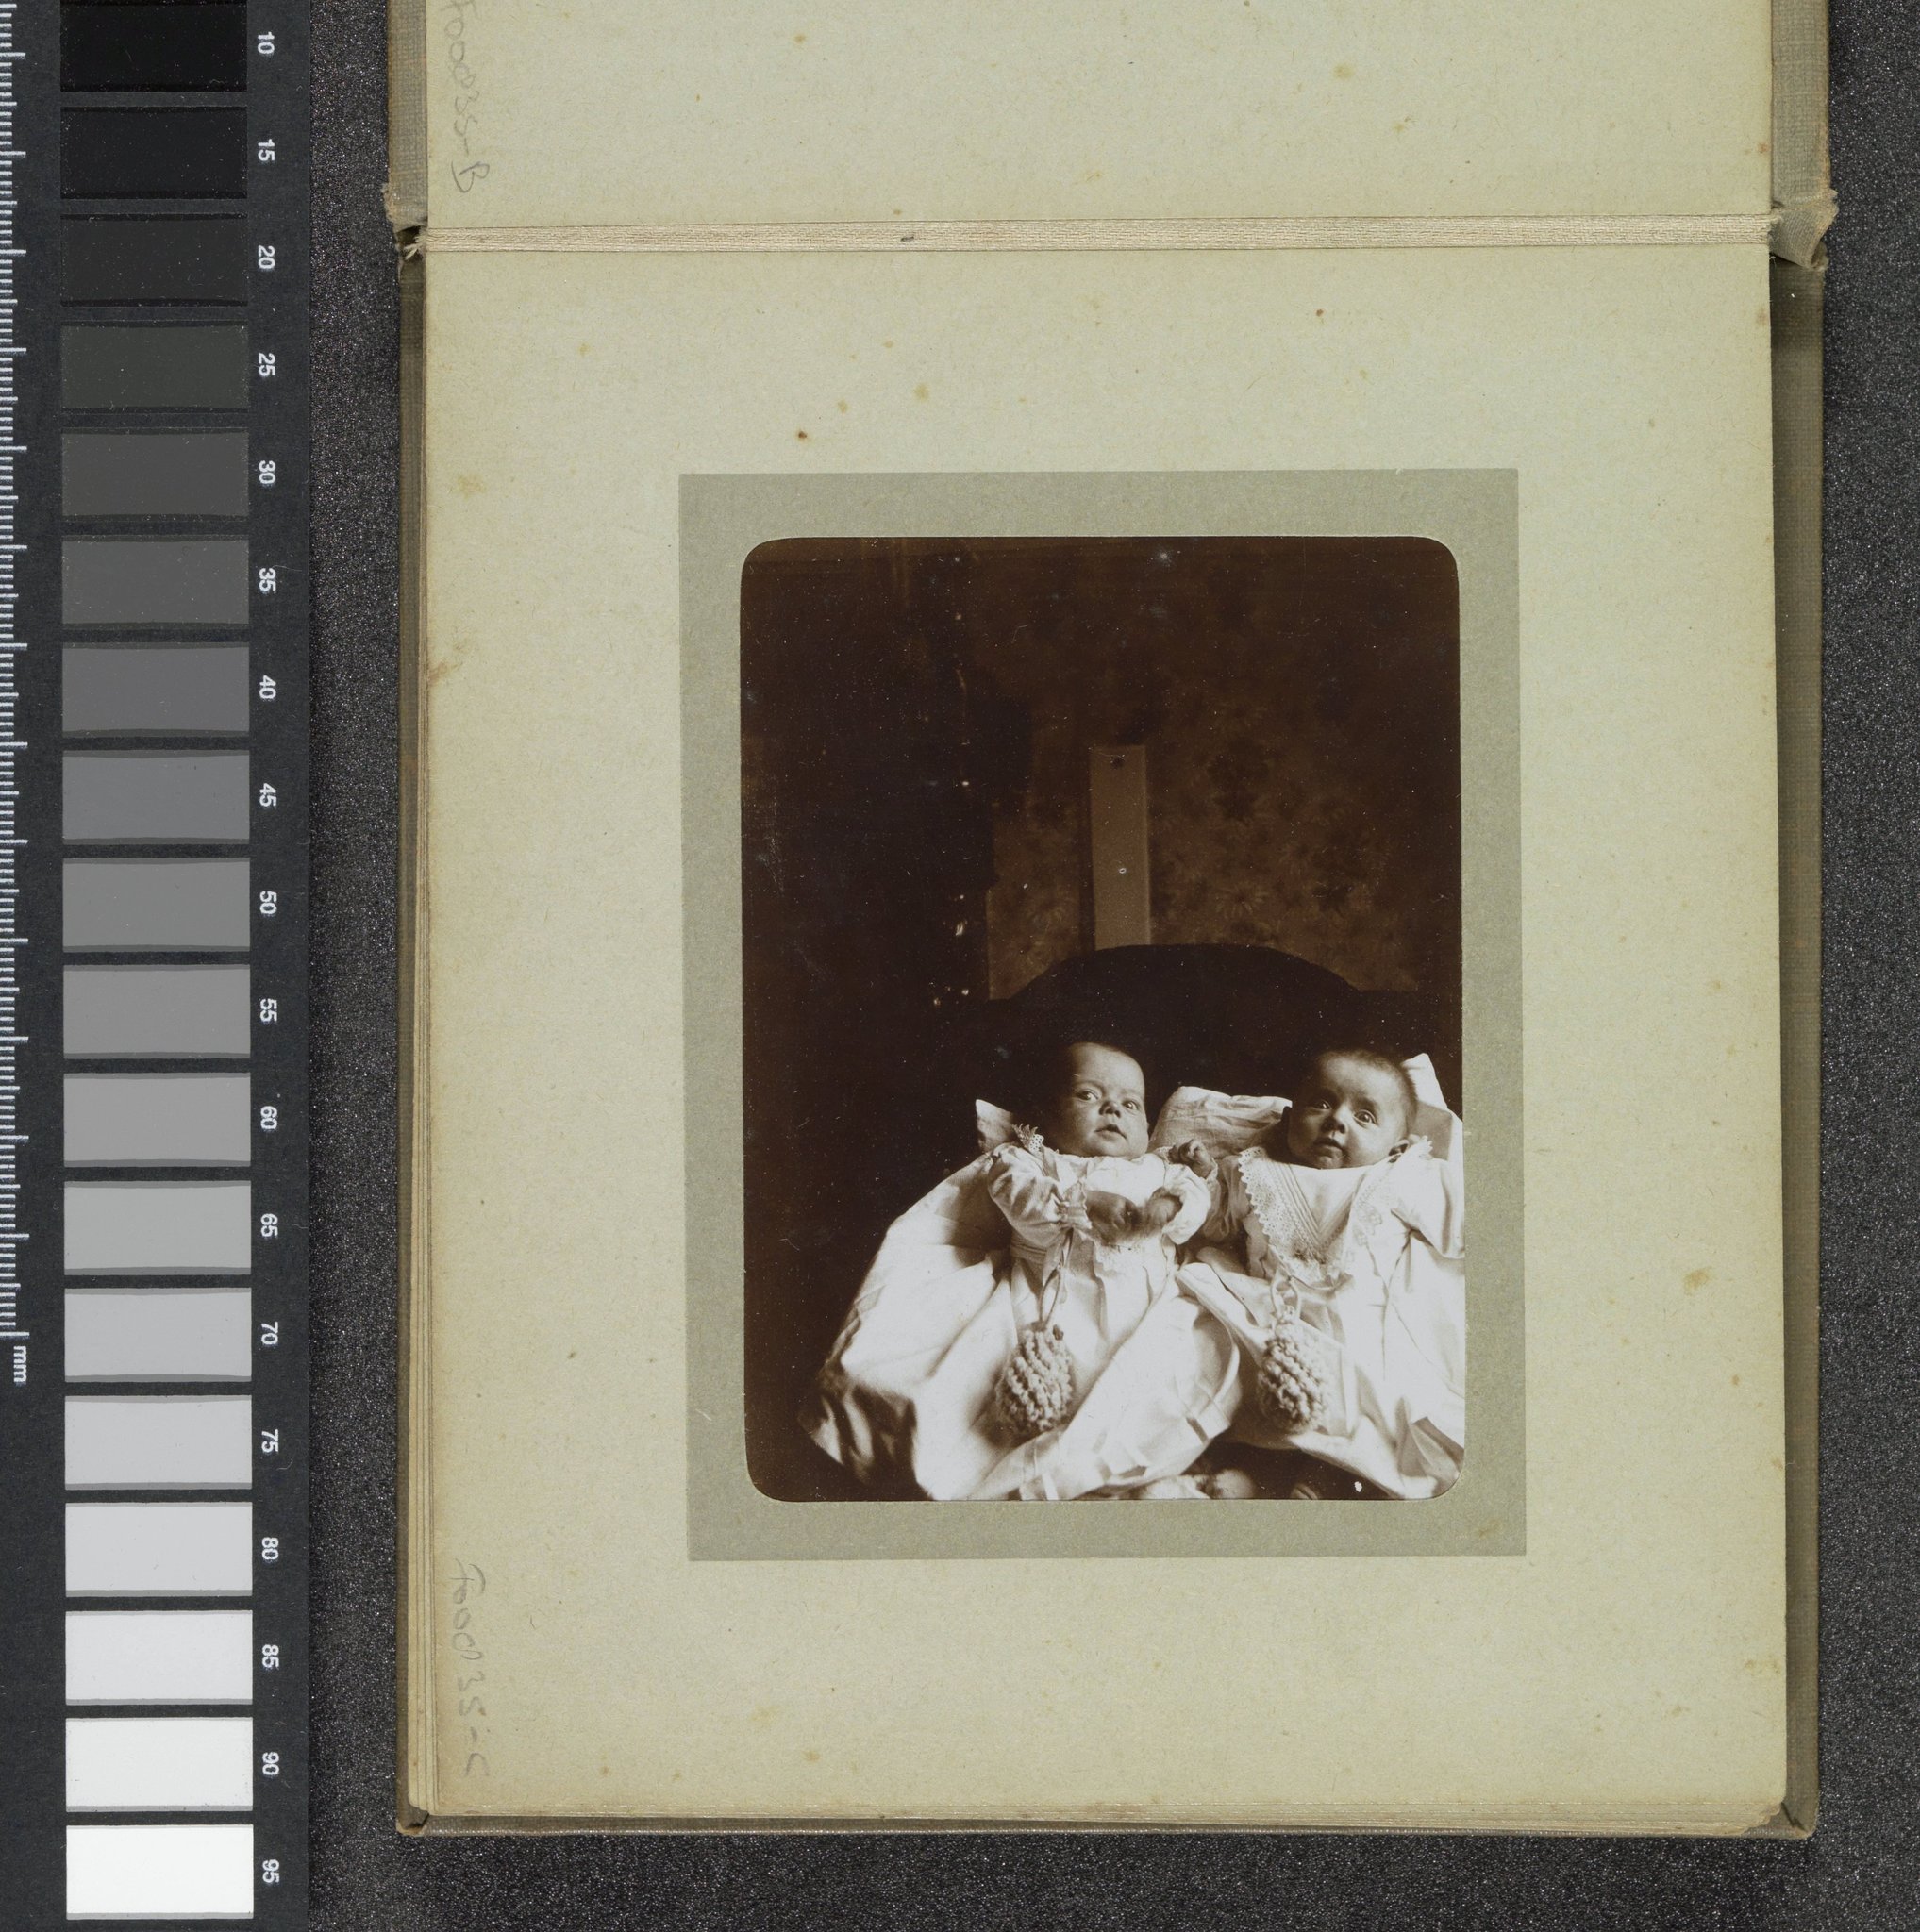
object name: photograph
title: Portret van twee baby's, waarschijnlijk de tweeling Ad en Johanna van der Kop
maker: willem carel van der kop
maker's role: amateurfotograaf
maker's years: 1869-1924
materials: cardboard, paper, photographic support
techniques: collodion silver print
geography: schoonhoven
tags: twins, family life, infant, baby, brothers or sisters (second degree family relationships)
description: Onderdeel van Fotoalbum met opnames van Ad, Johanna en Han van der Kop, hun moeder W.G. Hoogendijk en familieleden.